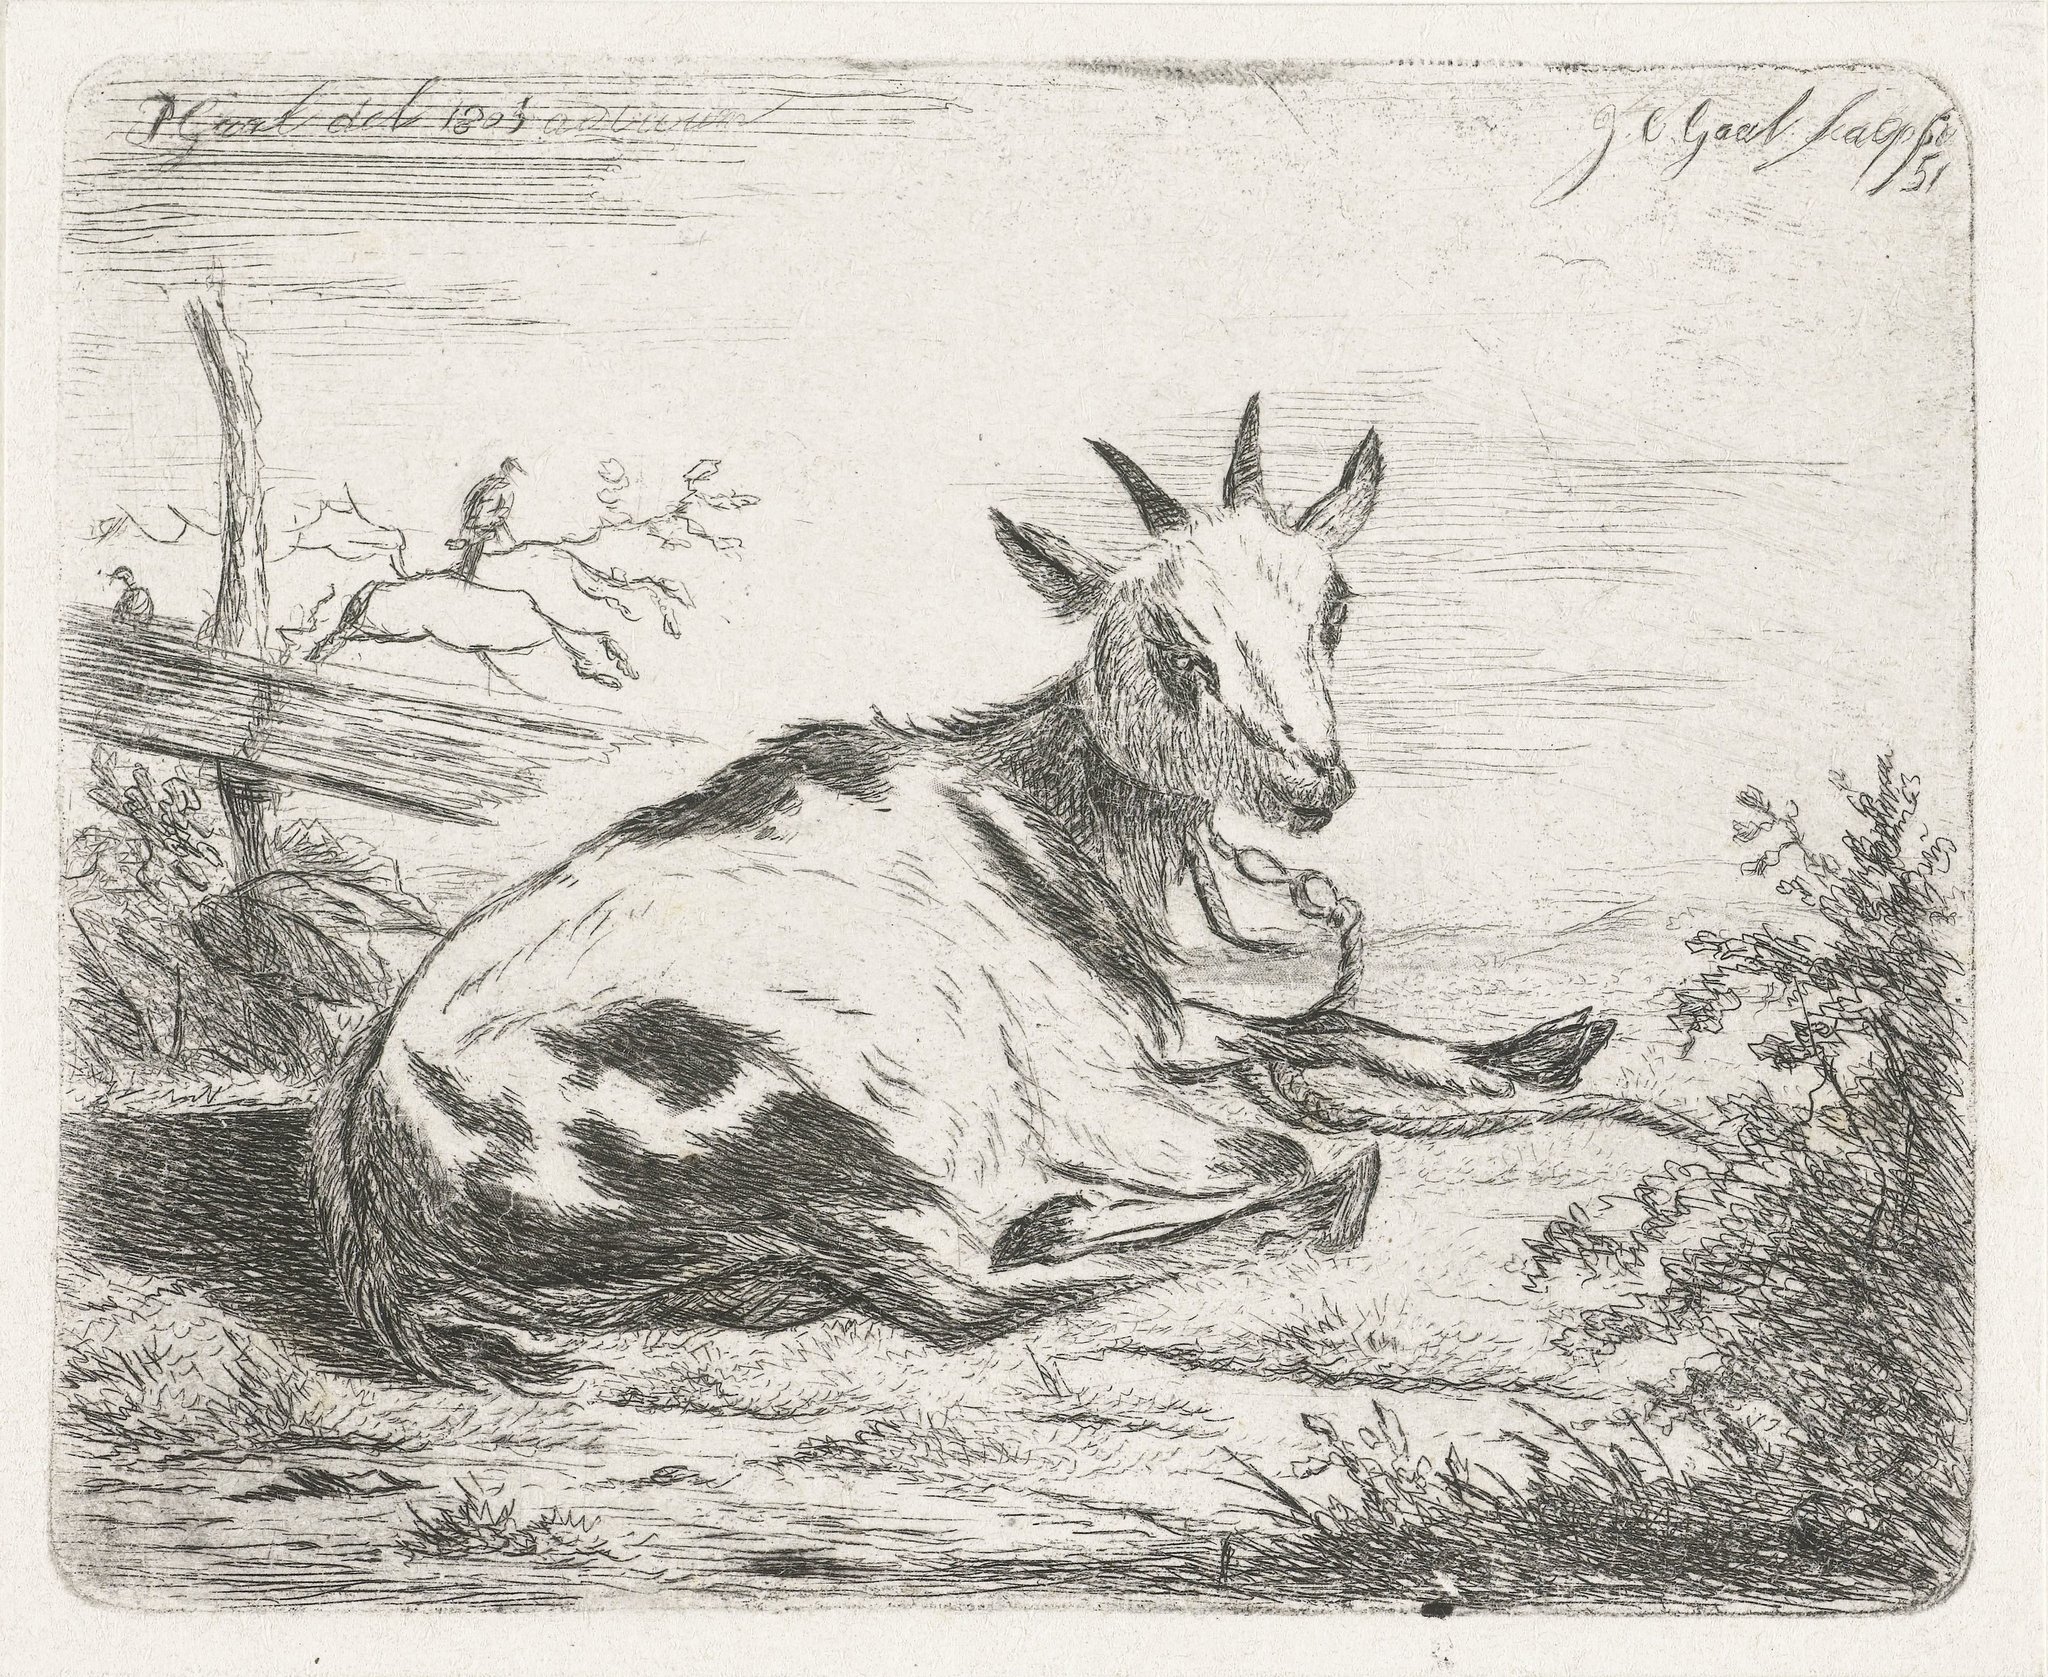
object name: print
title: Liggende geit, naar rechts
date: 1851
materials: paper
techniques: etching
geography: netherlands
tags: goat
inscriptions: collector's mark: Lugt 2228